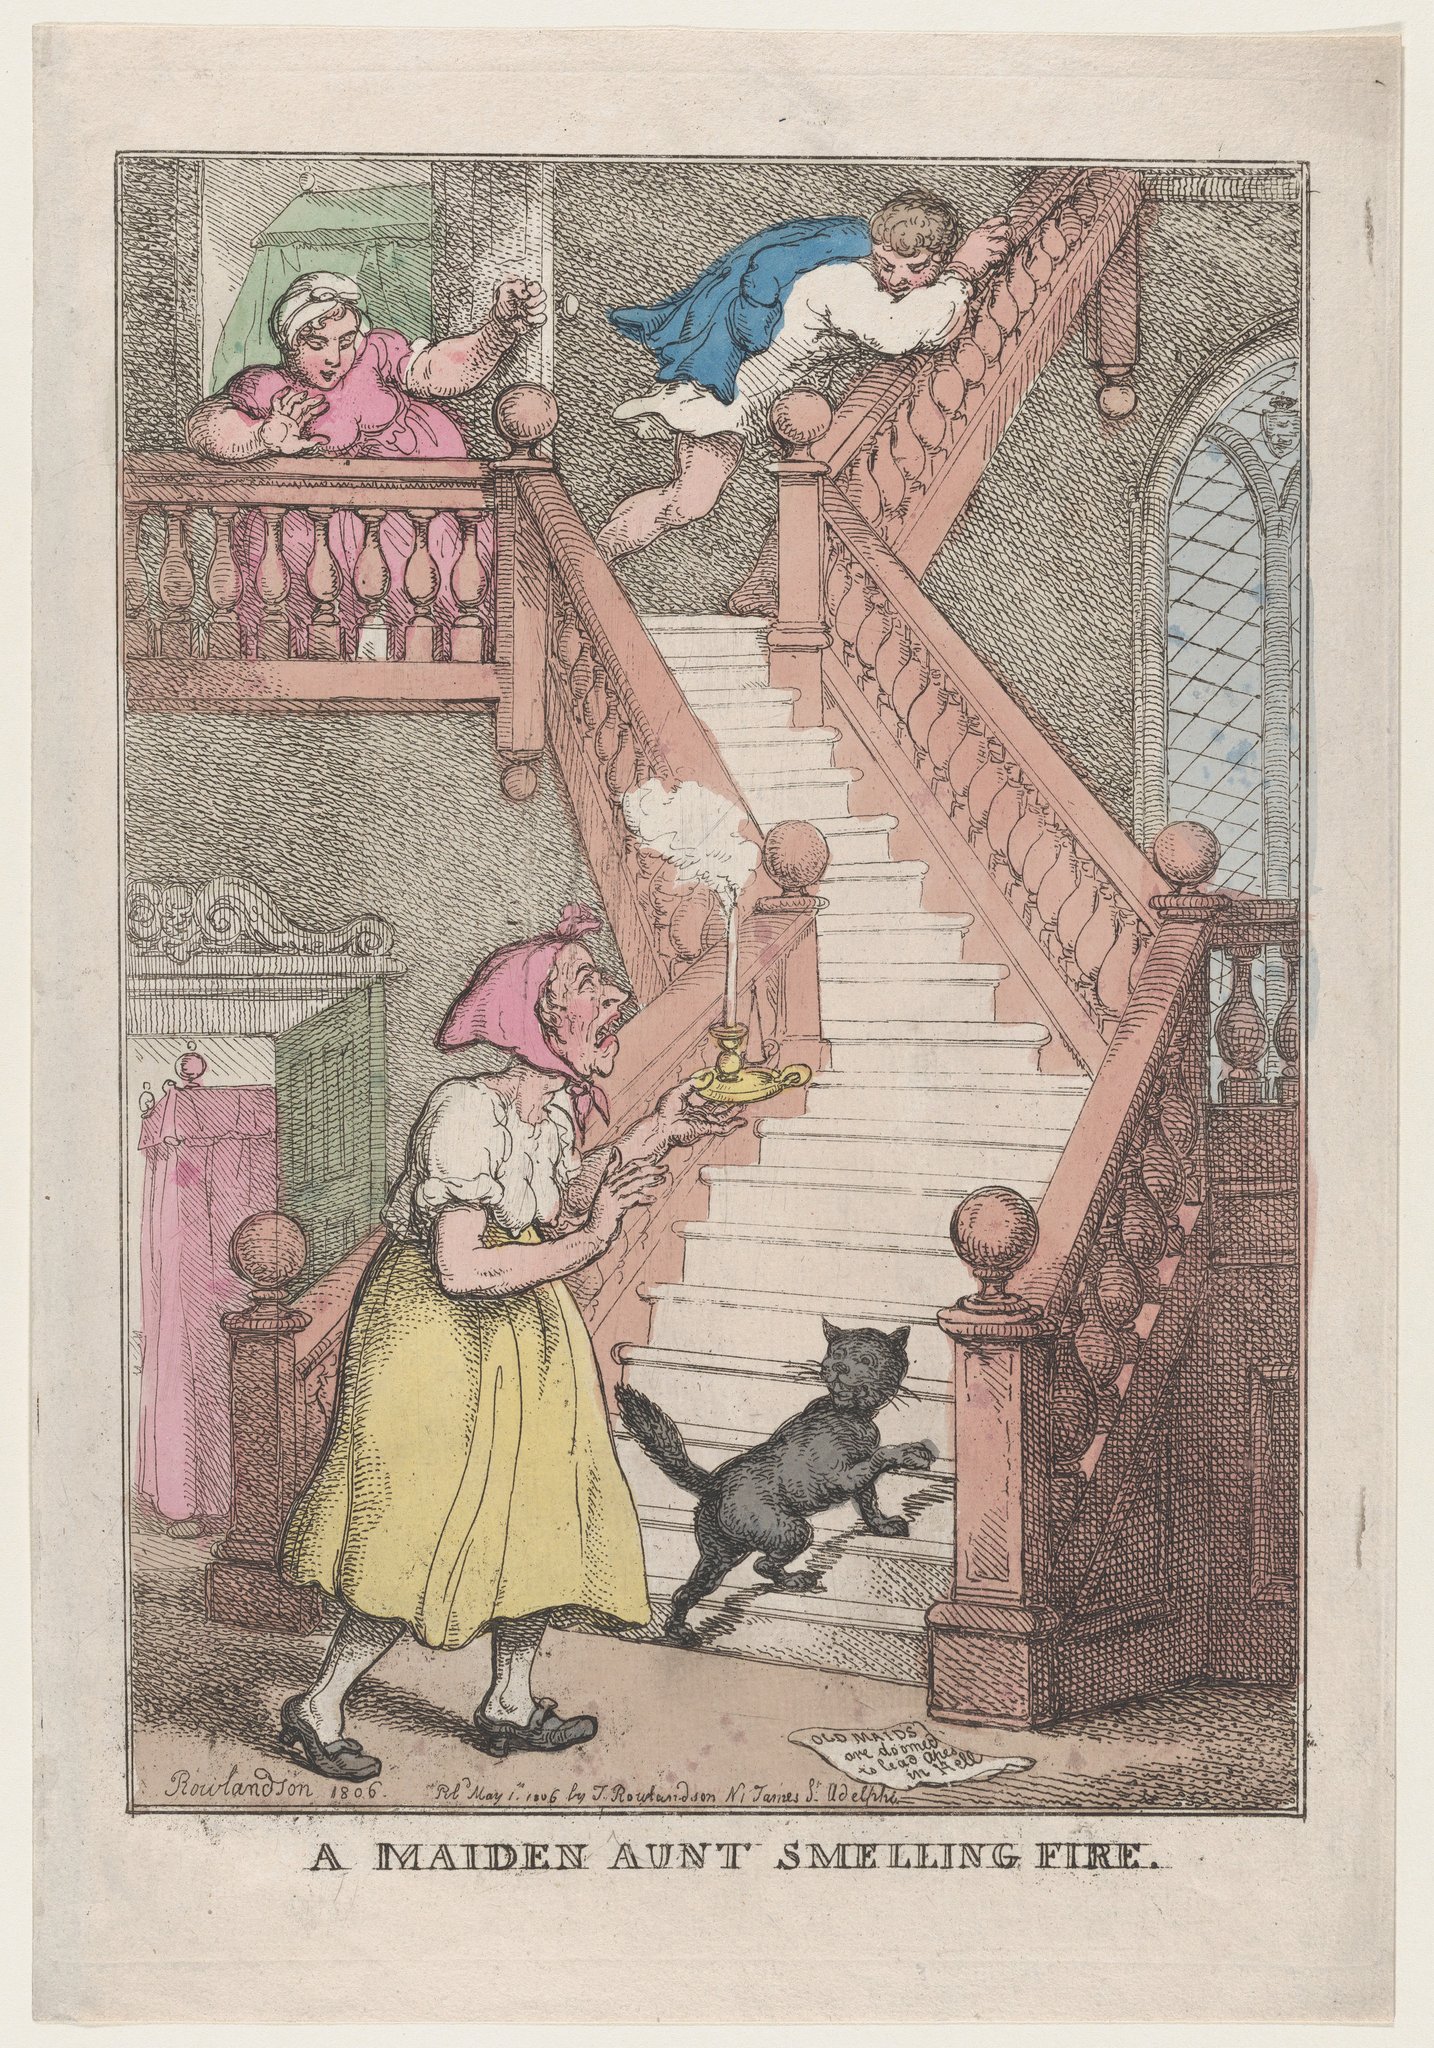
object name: print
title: A Maiden Aunt Smelling Fire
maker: thomas rowlandson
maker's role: artist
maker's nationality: british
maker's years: 1757-1827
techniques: etching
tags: satire,stairs,men,women,cats